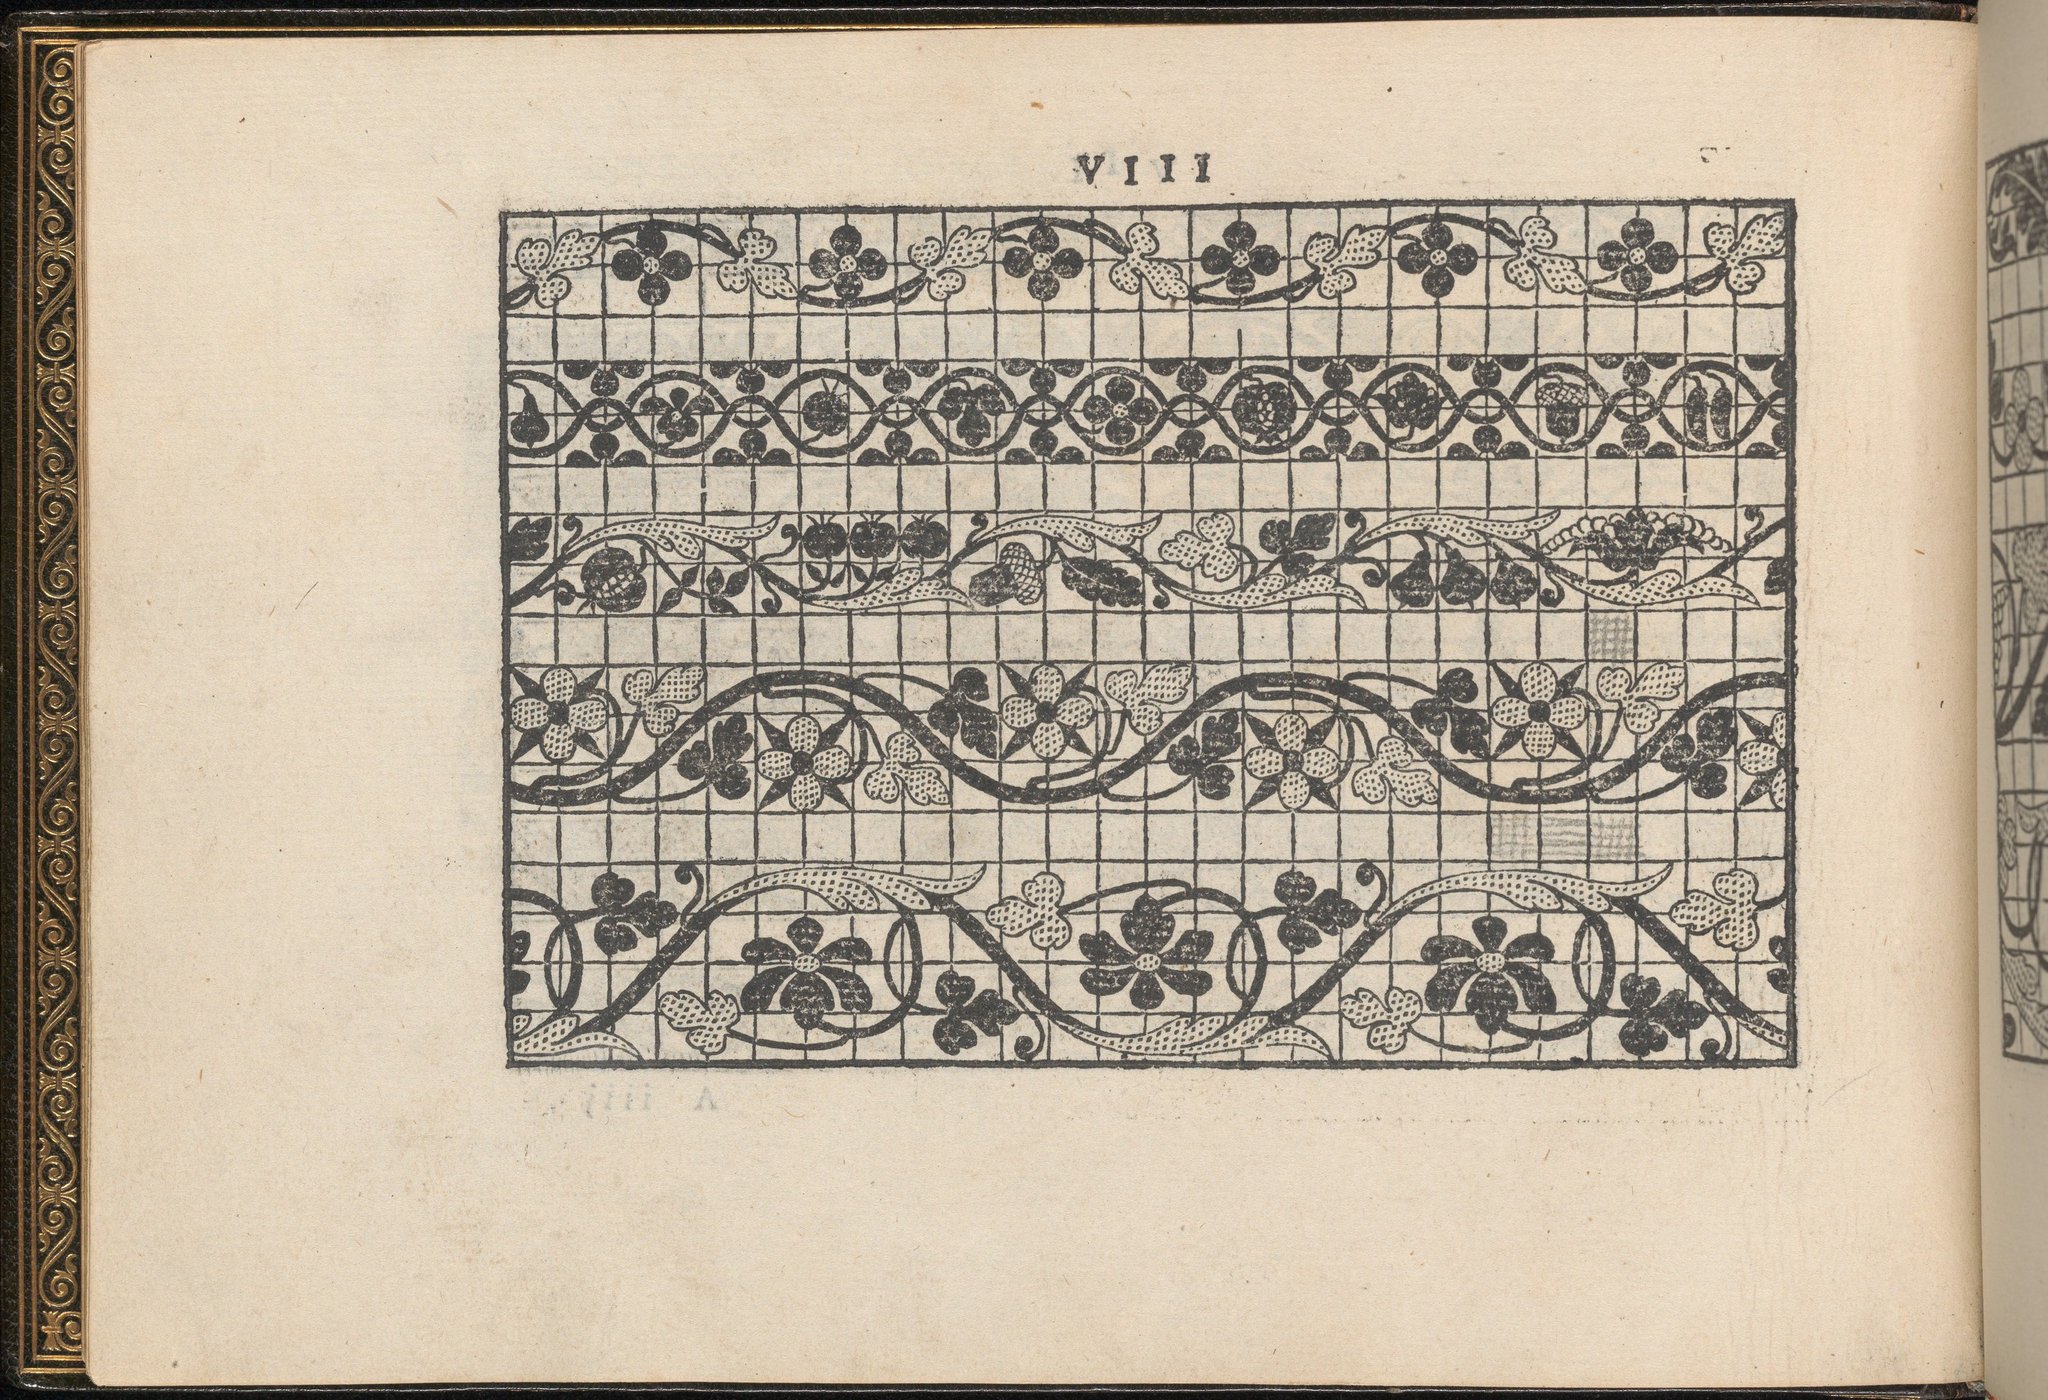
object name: book print ornament architecture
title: La Vera Perfettione del Disegno di varie sorti di recami, page 4 (verso)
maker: giovanni ostaus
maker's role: publisher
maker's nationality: italian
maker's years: 1507-1607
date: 1567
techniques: woodcut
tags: flowers,vines